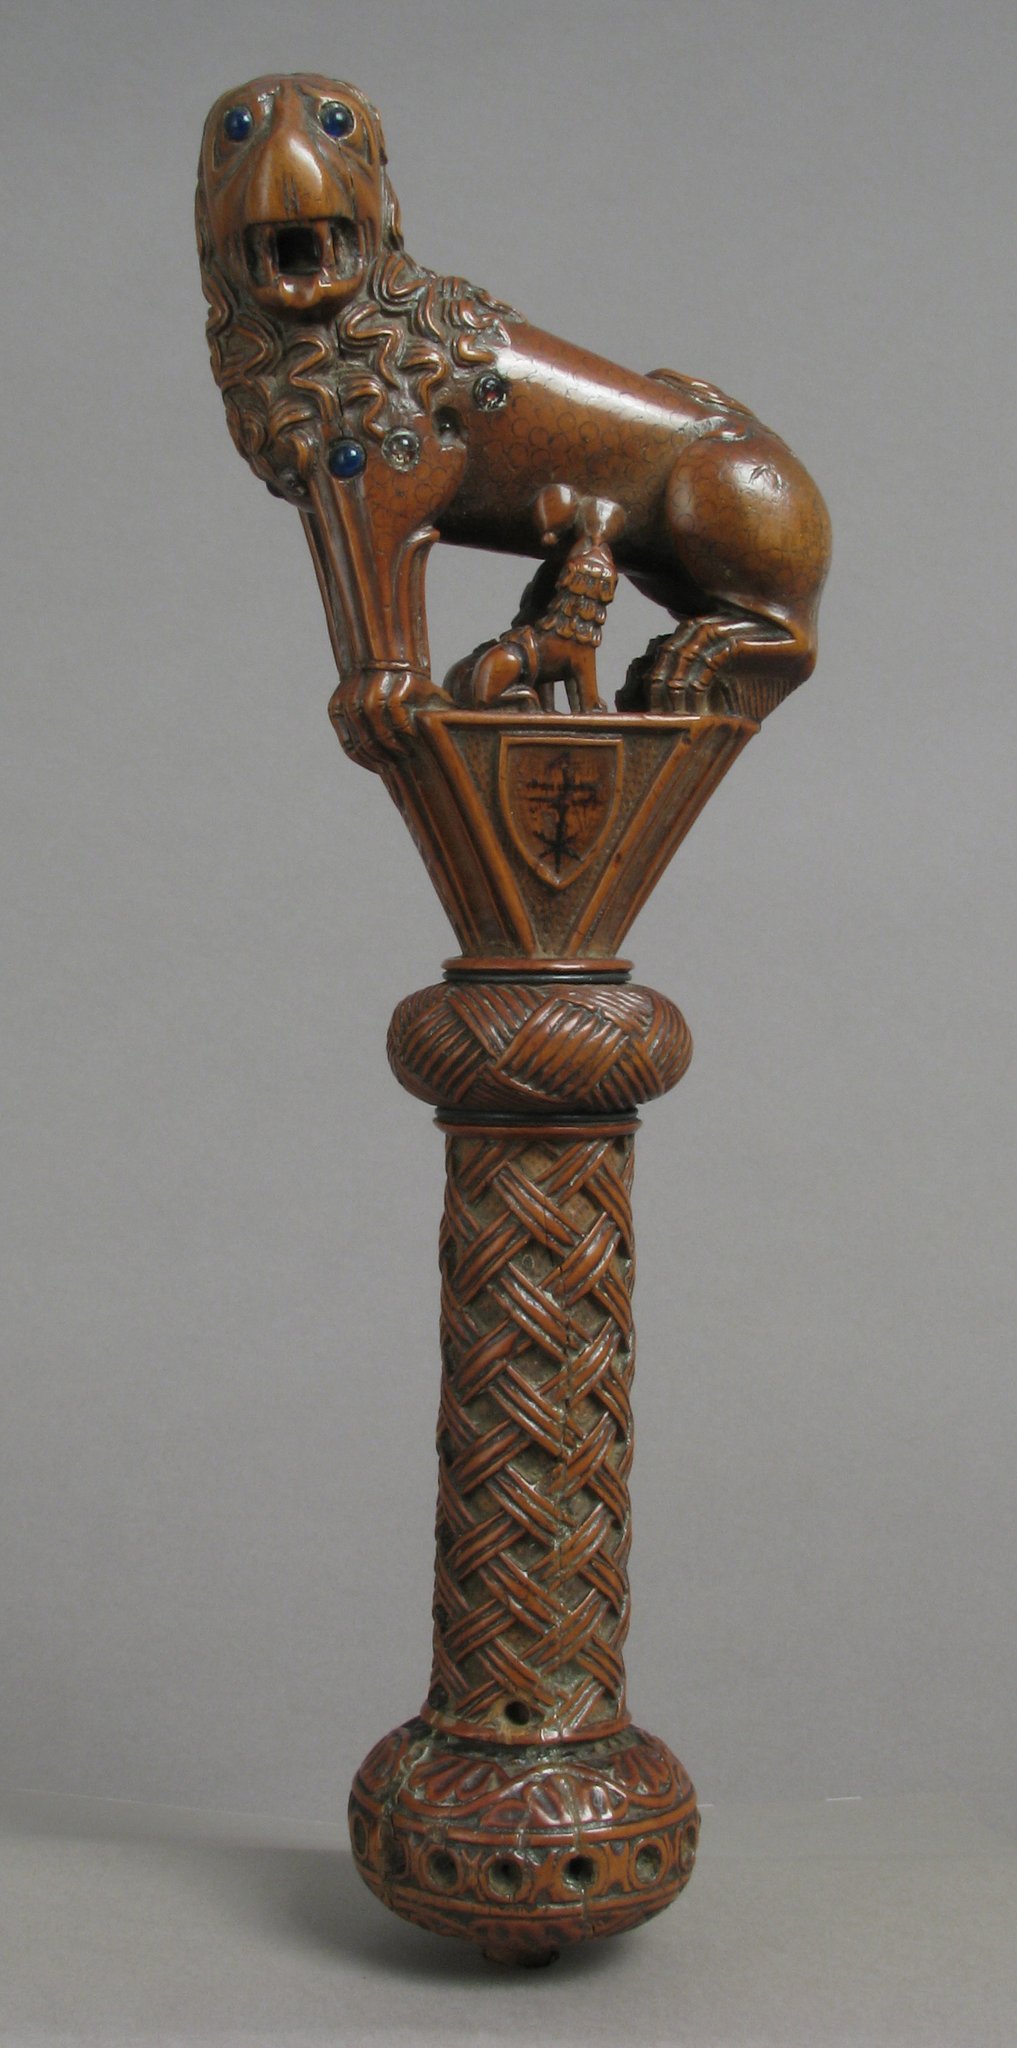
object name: staff head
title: Head of Staff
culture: italian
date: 1801-1900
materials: copper alloy, glass, metal, wood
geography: venice (?)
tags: lions